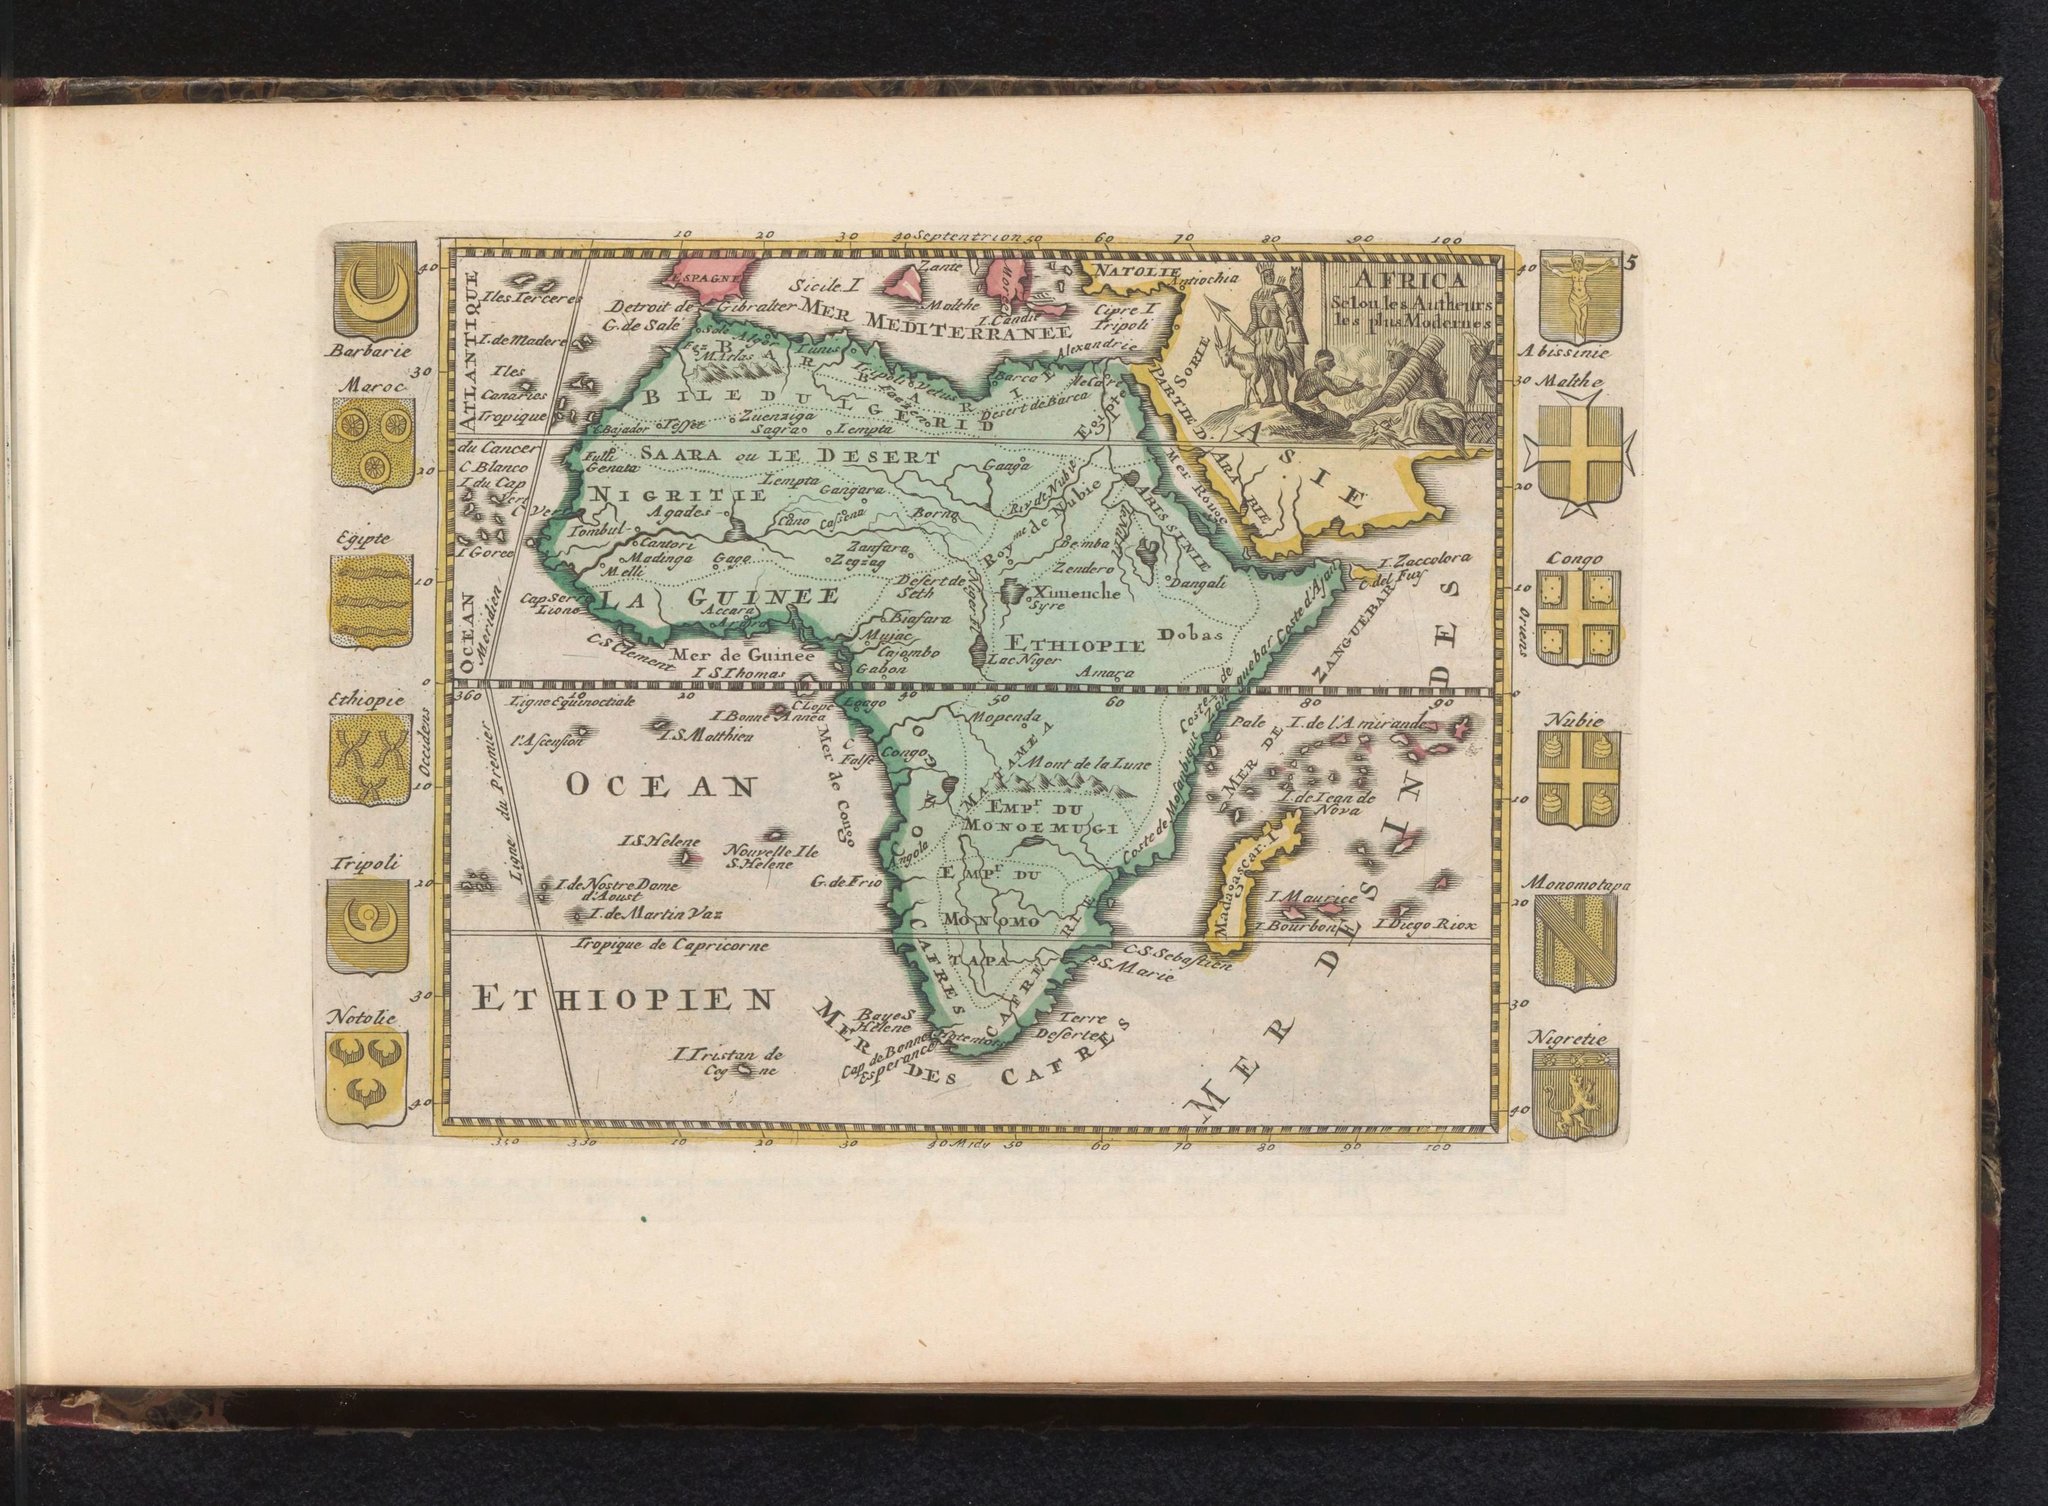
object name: print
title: Africa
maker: Anonymous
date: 1700-1705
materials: paper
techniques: engraving, hand coloring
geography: northern netherlands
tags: (map of) africa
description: Kaart van Afrika, rechtsboven een vignet met Afrikanen rond een vuur. Aan de zijkanten twaalf wapens van landen. Onderdeel van een atlas met 223 kaarten van landen en steden en oorlogstaferelen in Europa in de periode ca. 1690-1735.